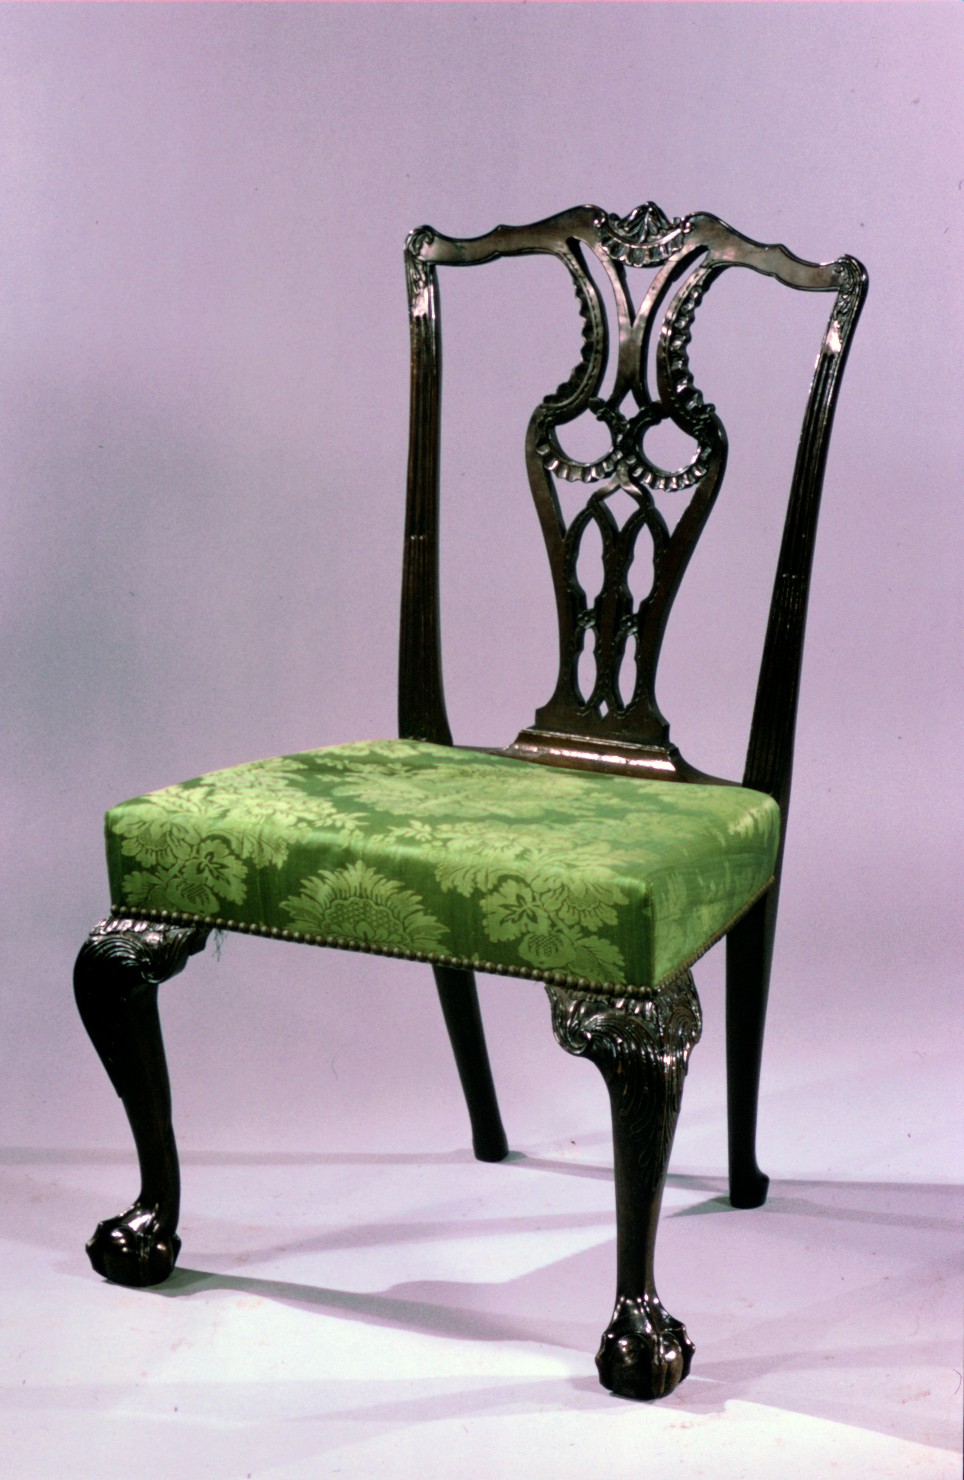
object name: side chair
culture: american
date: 1770-1790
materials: wood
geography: united states